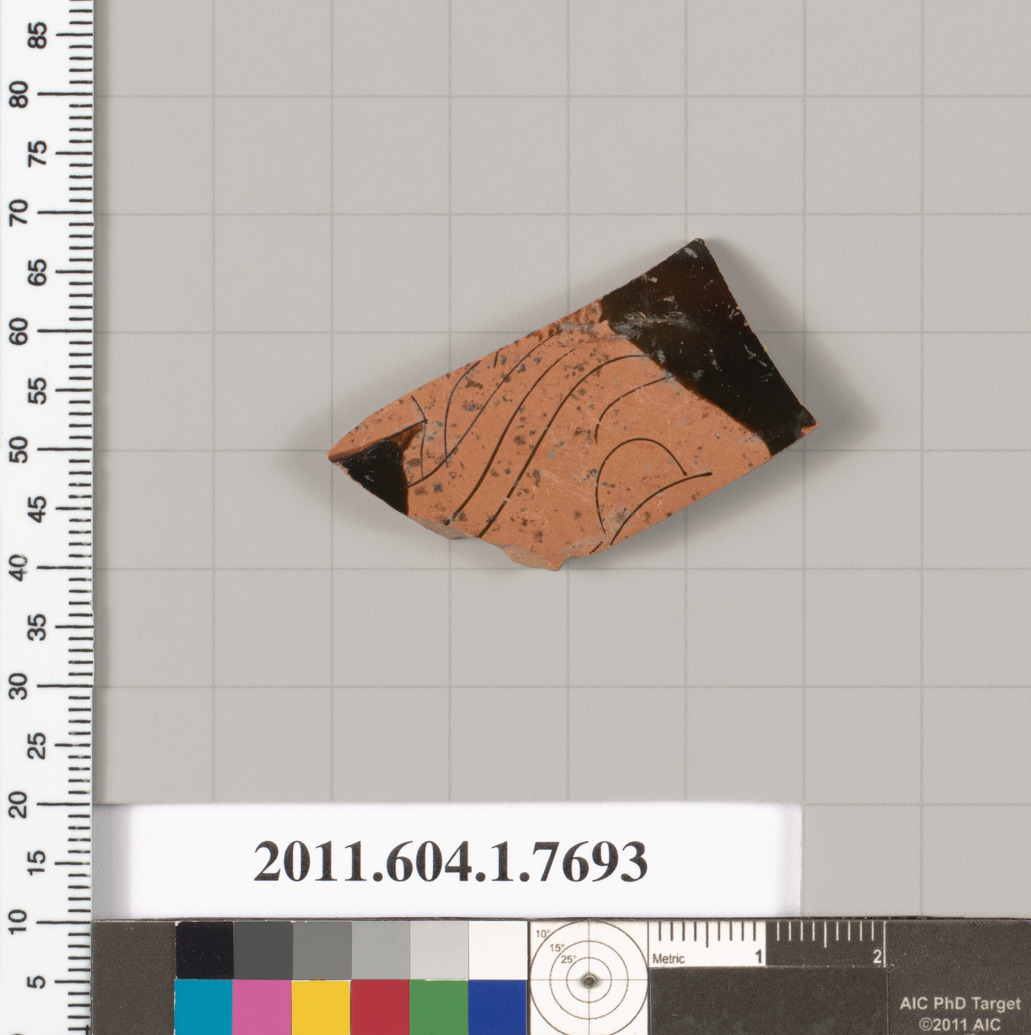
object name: kylix fragment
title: Terracotta fragment of a kylix (drinking cup)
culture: greek, attic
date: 460-450 BCE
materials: terracotta